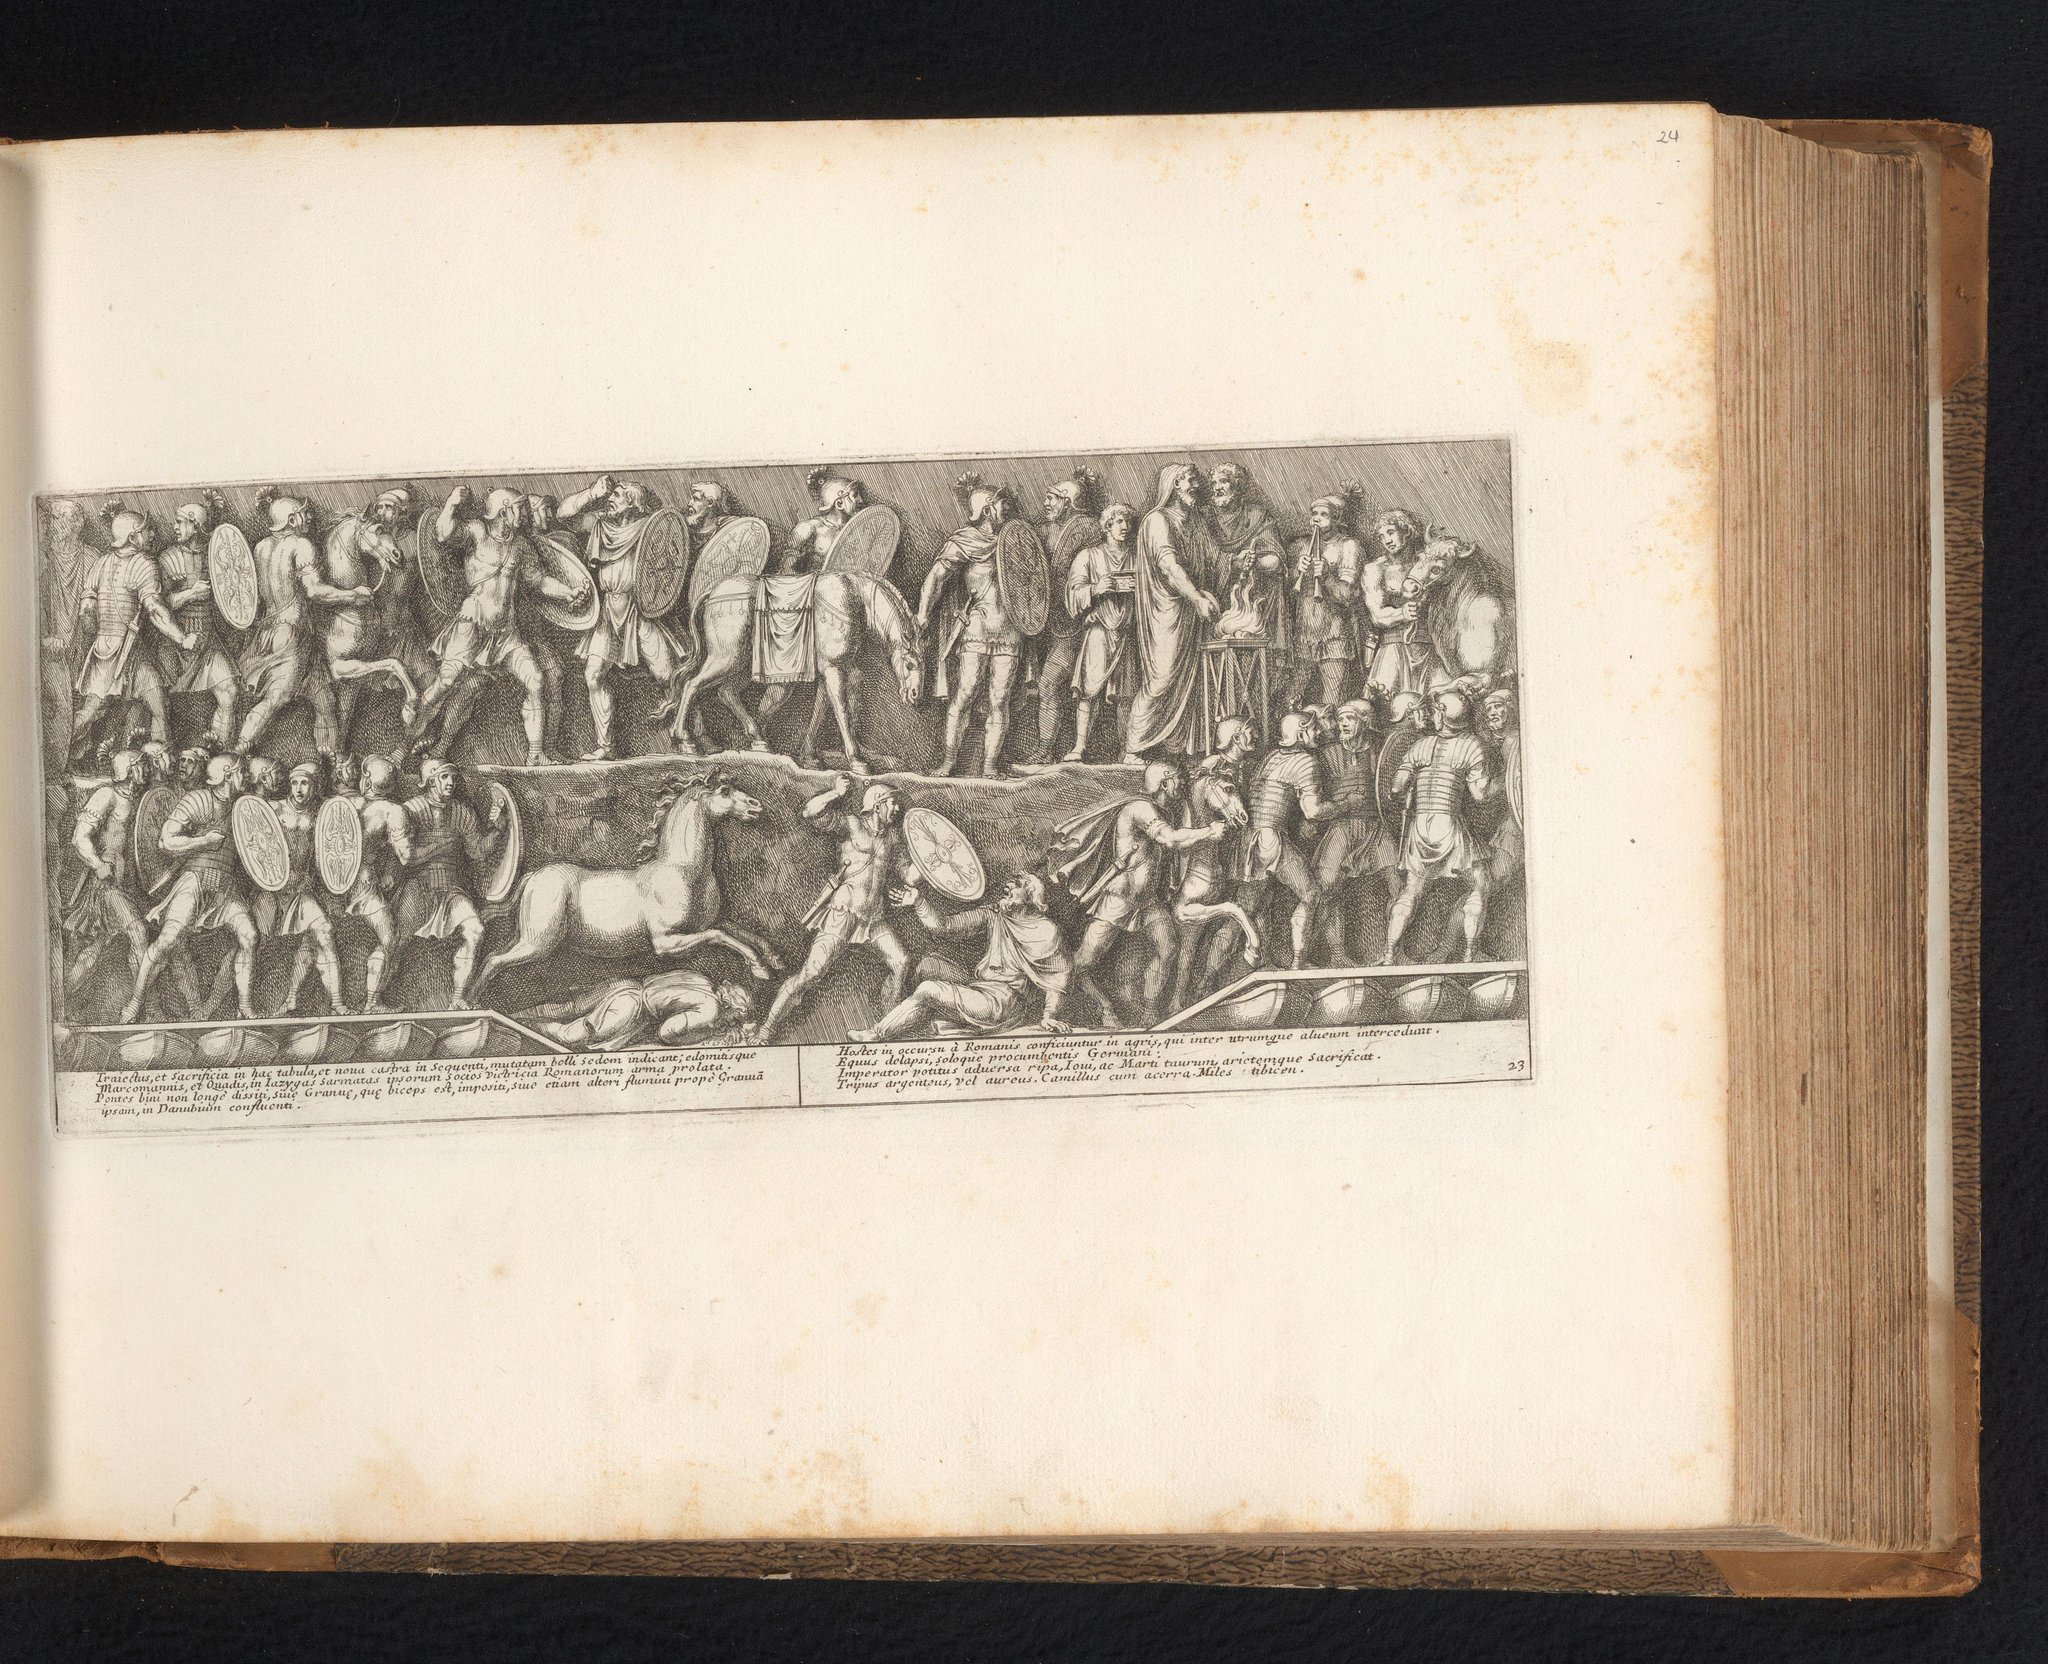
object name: album leaf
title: Detail van het fries op de Zuil van Marcus Aurelius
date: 1672-1675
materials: paper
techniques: etching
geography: rome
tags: triumphal column with helical friezes, piece of sculpture, reproduction of a piece of sculpture, the soldier; the soldier's life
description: Detail van het spiraalvormige gebeeldhouwde fries op de Zuil van Marcus Aurelius te Rome. Het fries toont de oorlog tussen het Romeinse leger van keizer Marcus Aurelius en de Germaanse stammen der Marcomannen en Quaden en de oorlog tegen de Sarmaten die vanuit het huidige Iran Hongarije waren binnengevallen. Tekst in de ondermarge. Prent maakt deel uit van een album.